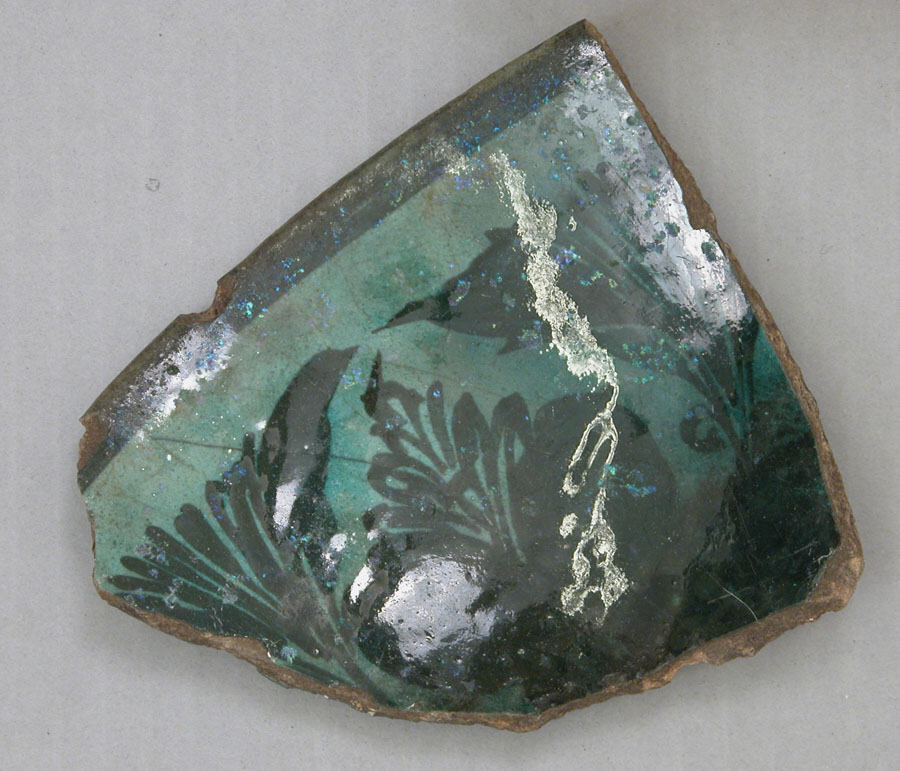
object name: fragment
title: Ceramic Fragment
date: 1401-1500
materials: earthenware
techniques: glazing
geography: egypt